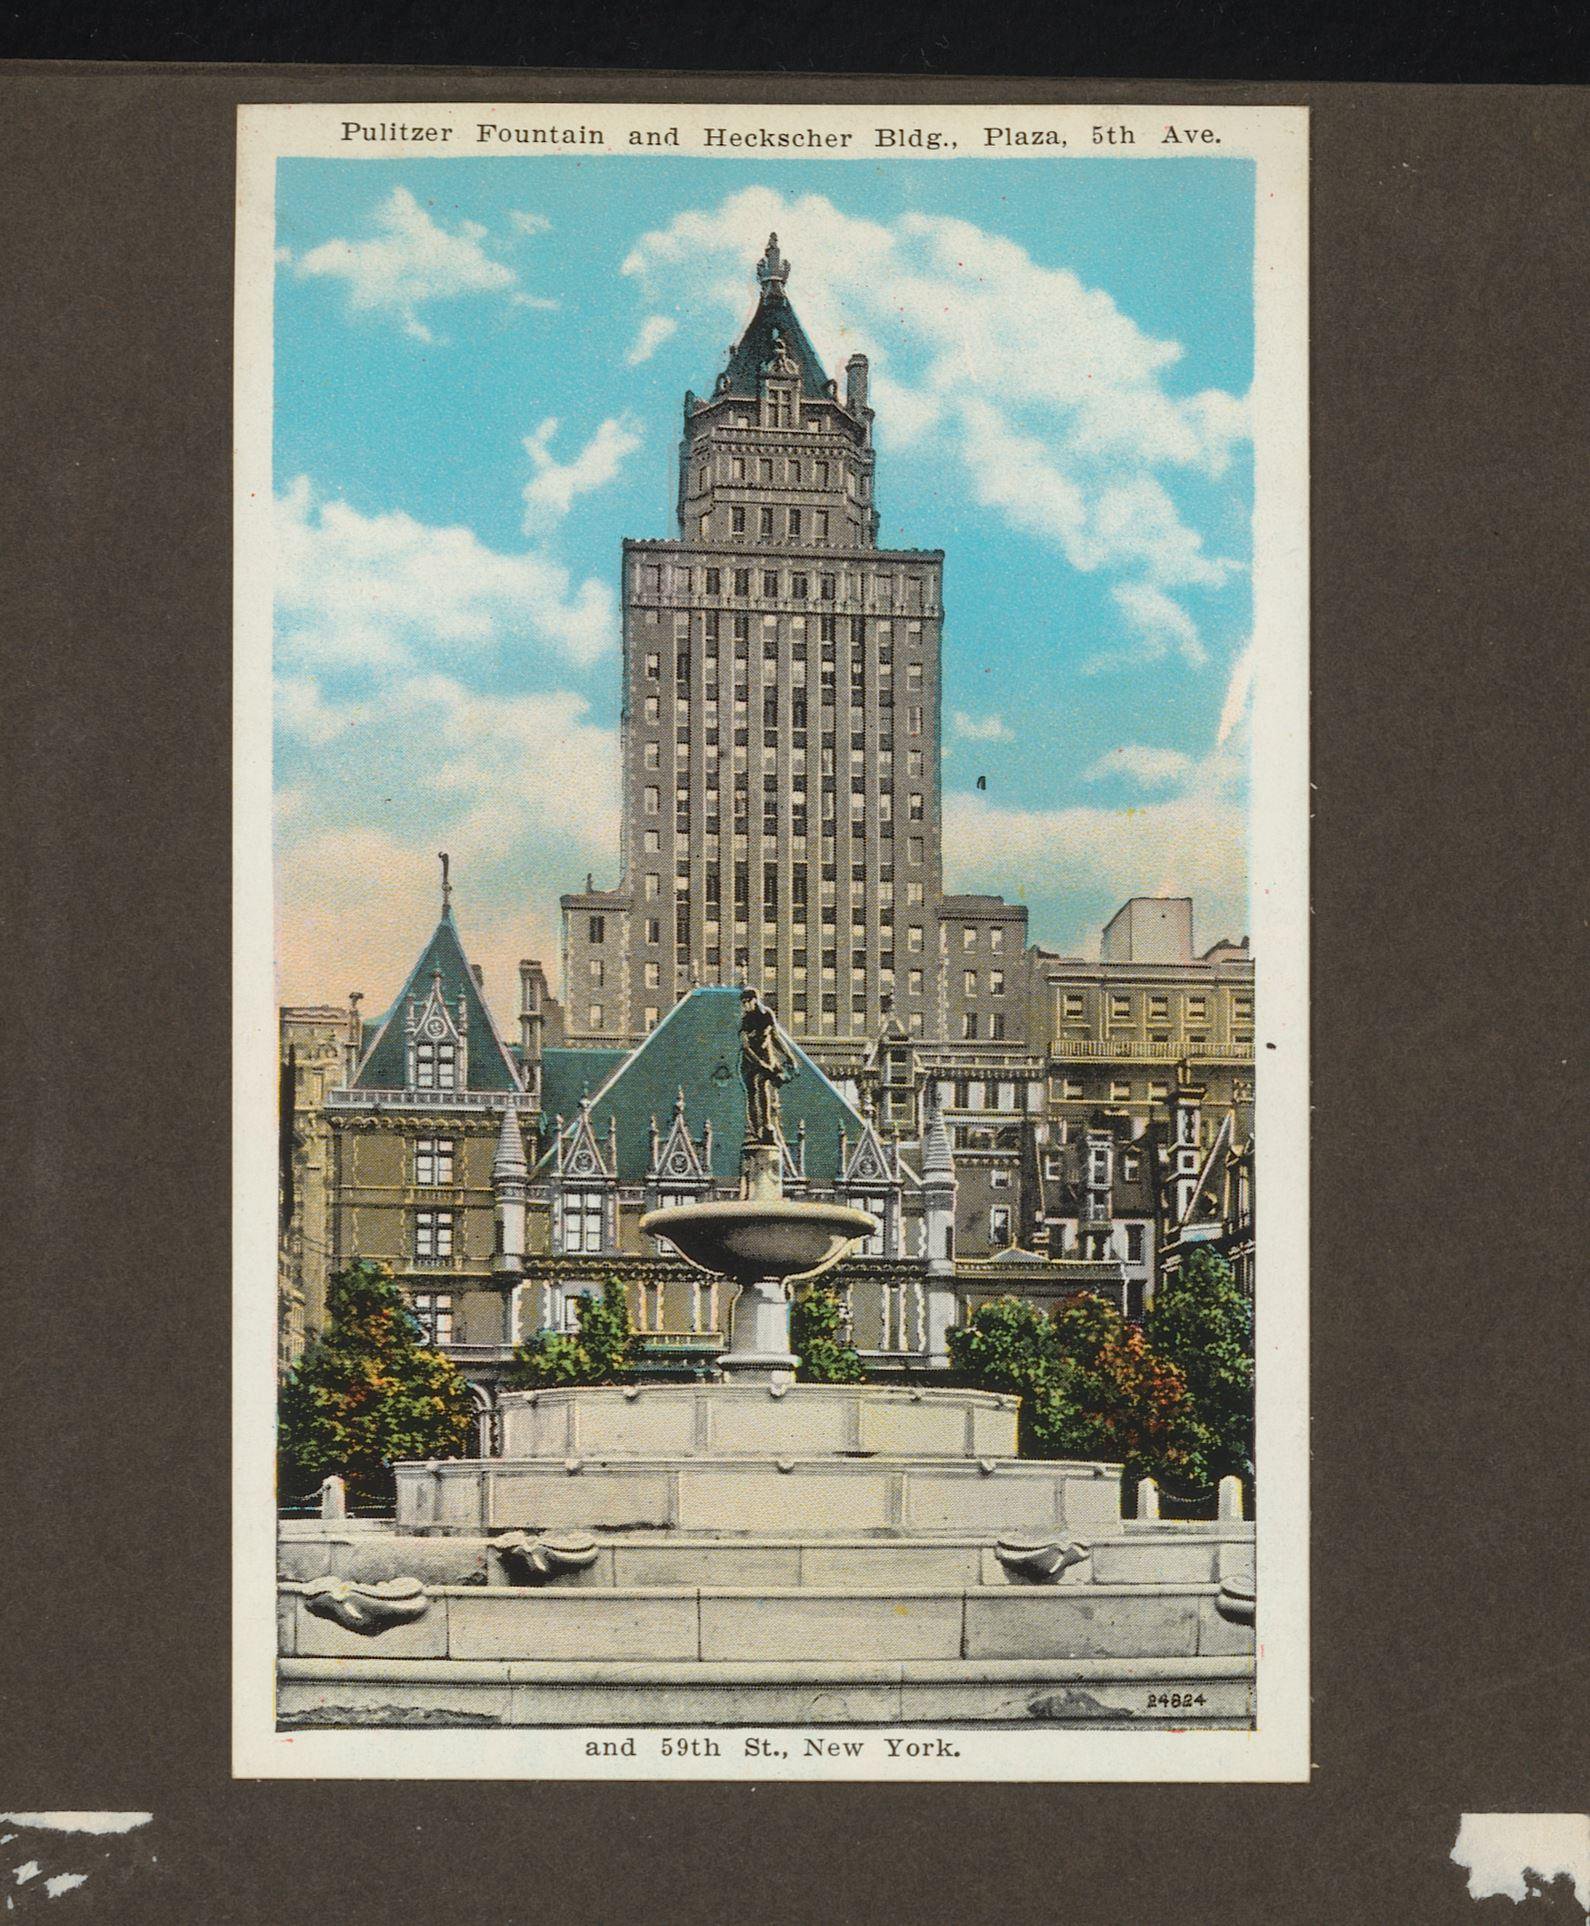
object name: photomechanical print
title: Pulitzer fountain and Heckscher Bldg. Plaza 5th. Ave and 59th St.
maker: Anonymous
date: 1928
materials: paper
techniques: four-color autotype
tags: skyscraper, ornamental fountain, new york (city)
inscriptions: number: ‘24824’